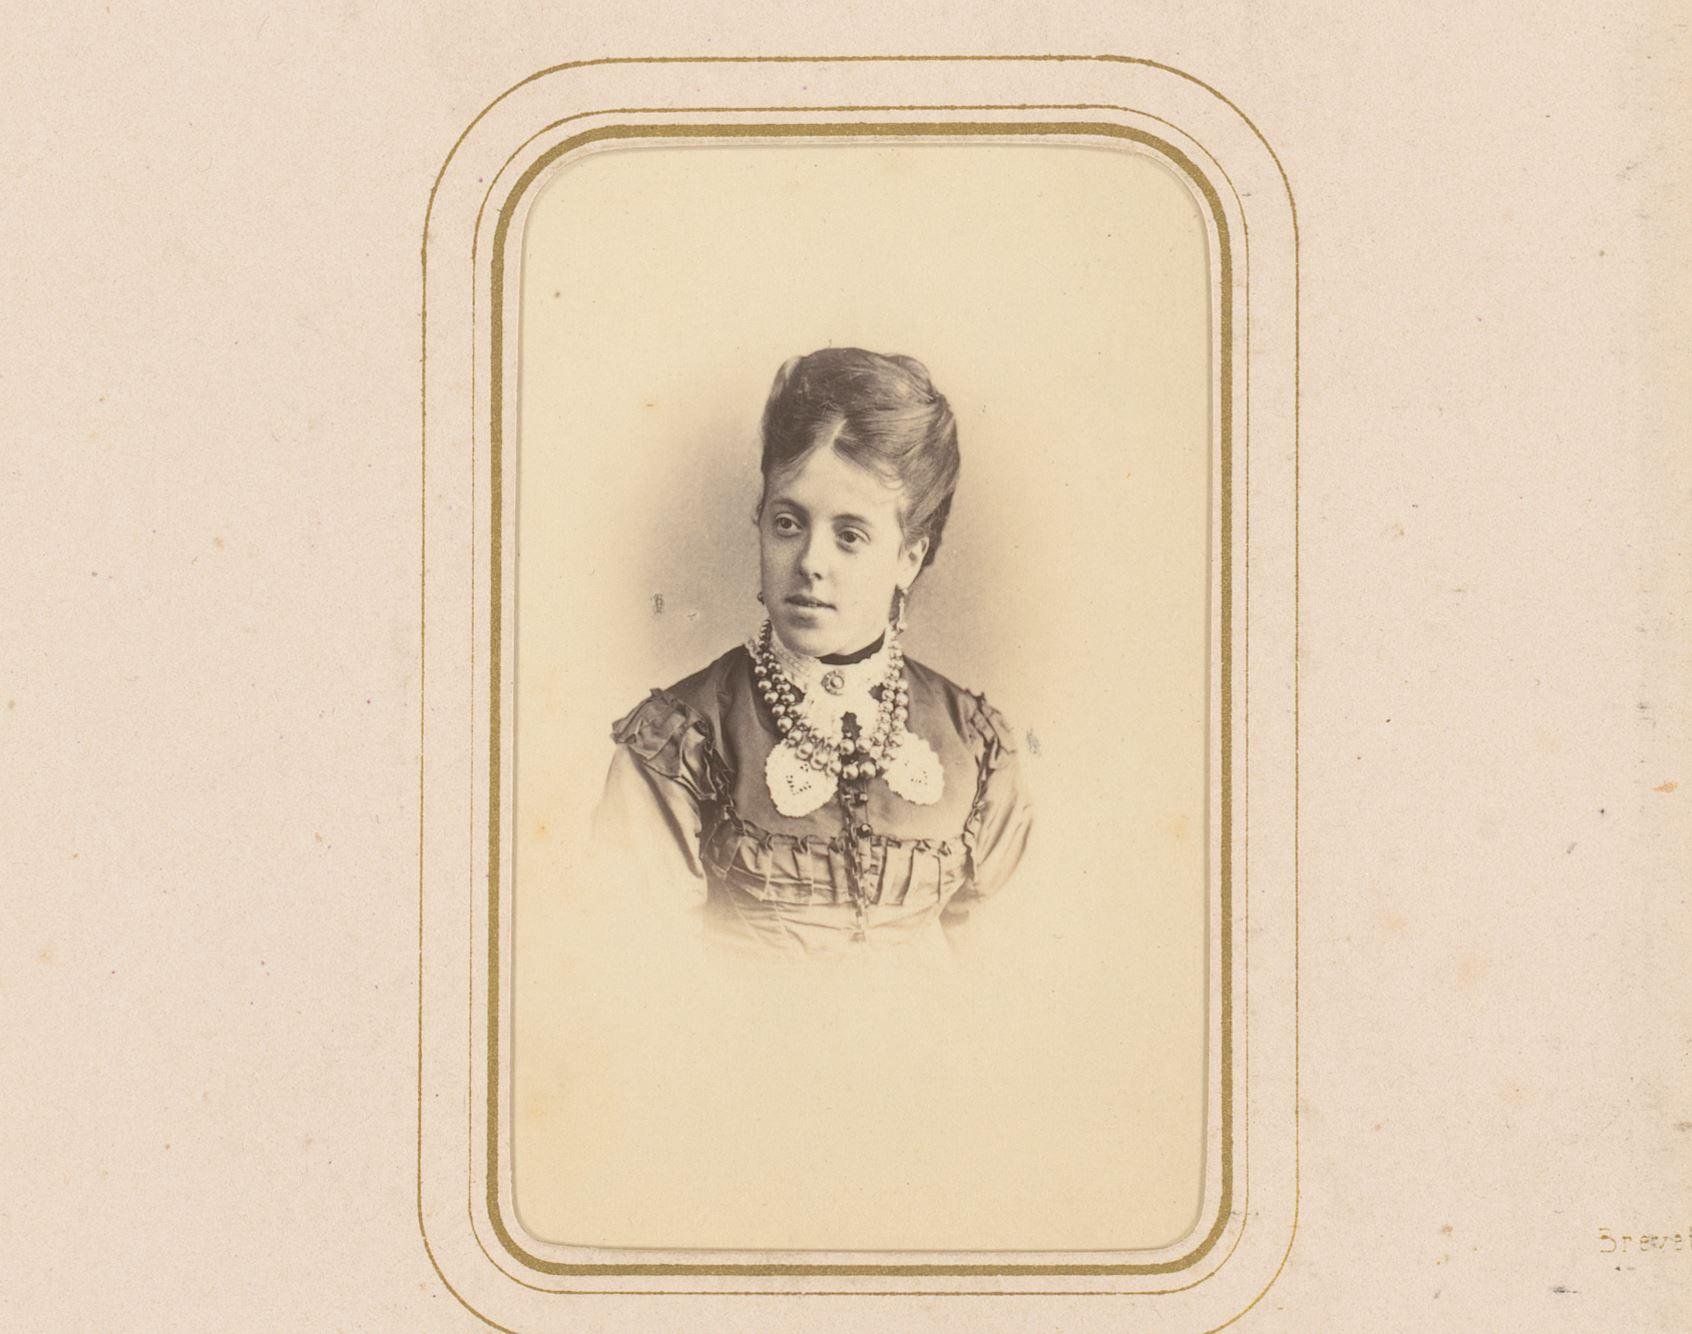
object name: carte de visite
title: Portret van een jonge vrouw met oorbellen en halsketting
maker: richard boning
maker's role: fotograaf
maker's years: 1826-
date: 1850-1870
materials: cardboard, photographic support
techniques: albumen print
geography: hastings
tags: adolescent, young woman, maiden, historical persons - bb - woman, necklace, ear-rings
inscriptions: inscription: ‘R. BONING/ 10, VERULAM PLACE ST LEONARDS on SEA/ THIS PICTURE CAN BE ENLARGED TO/ ANY SIZE, AND A VALUABLE PAINTING/ PRODUCED ON PAPER OR CANVASS/ PRODUCED ON PAPER OR CANVASS/ THE LIKENESS CANNOT FAIL TO BE CORRECT’